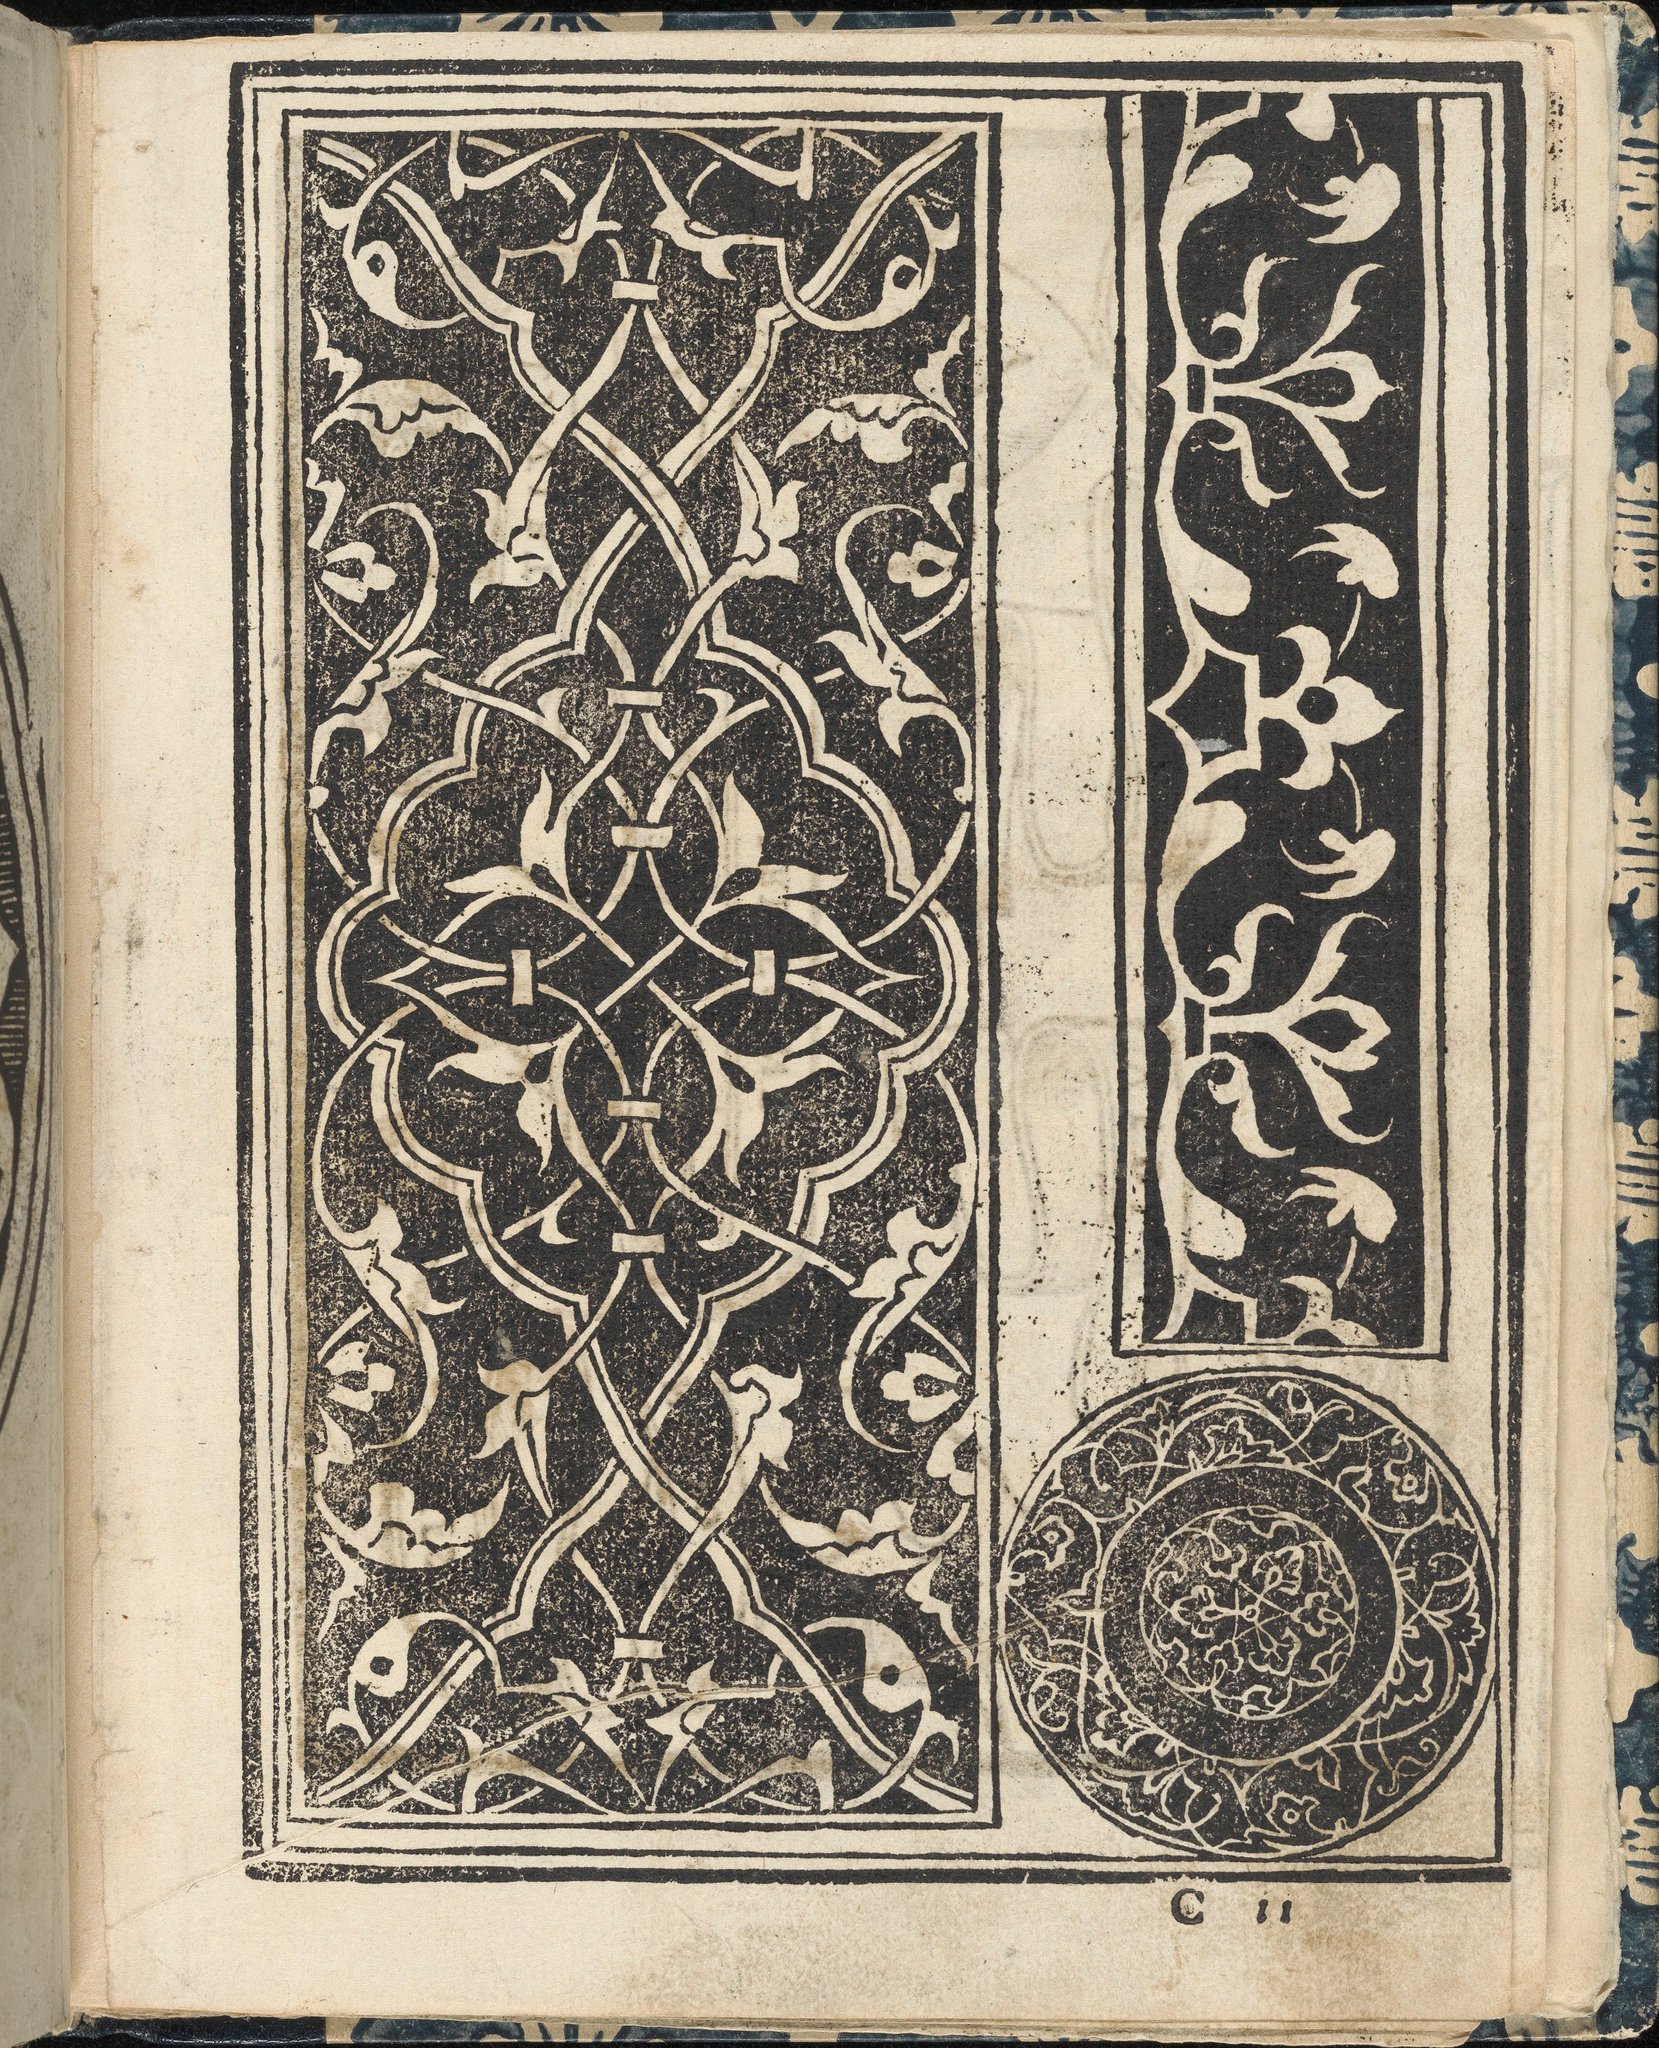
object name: book print ornament architecture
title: Essempio di recammi, page 18 (recto)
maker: giovanni antonio tagliente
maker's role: author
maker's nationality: italian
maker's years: 1465-1528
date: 1530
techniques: woodcut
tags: ornament